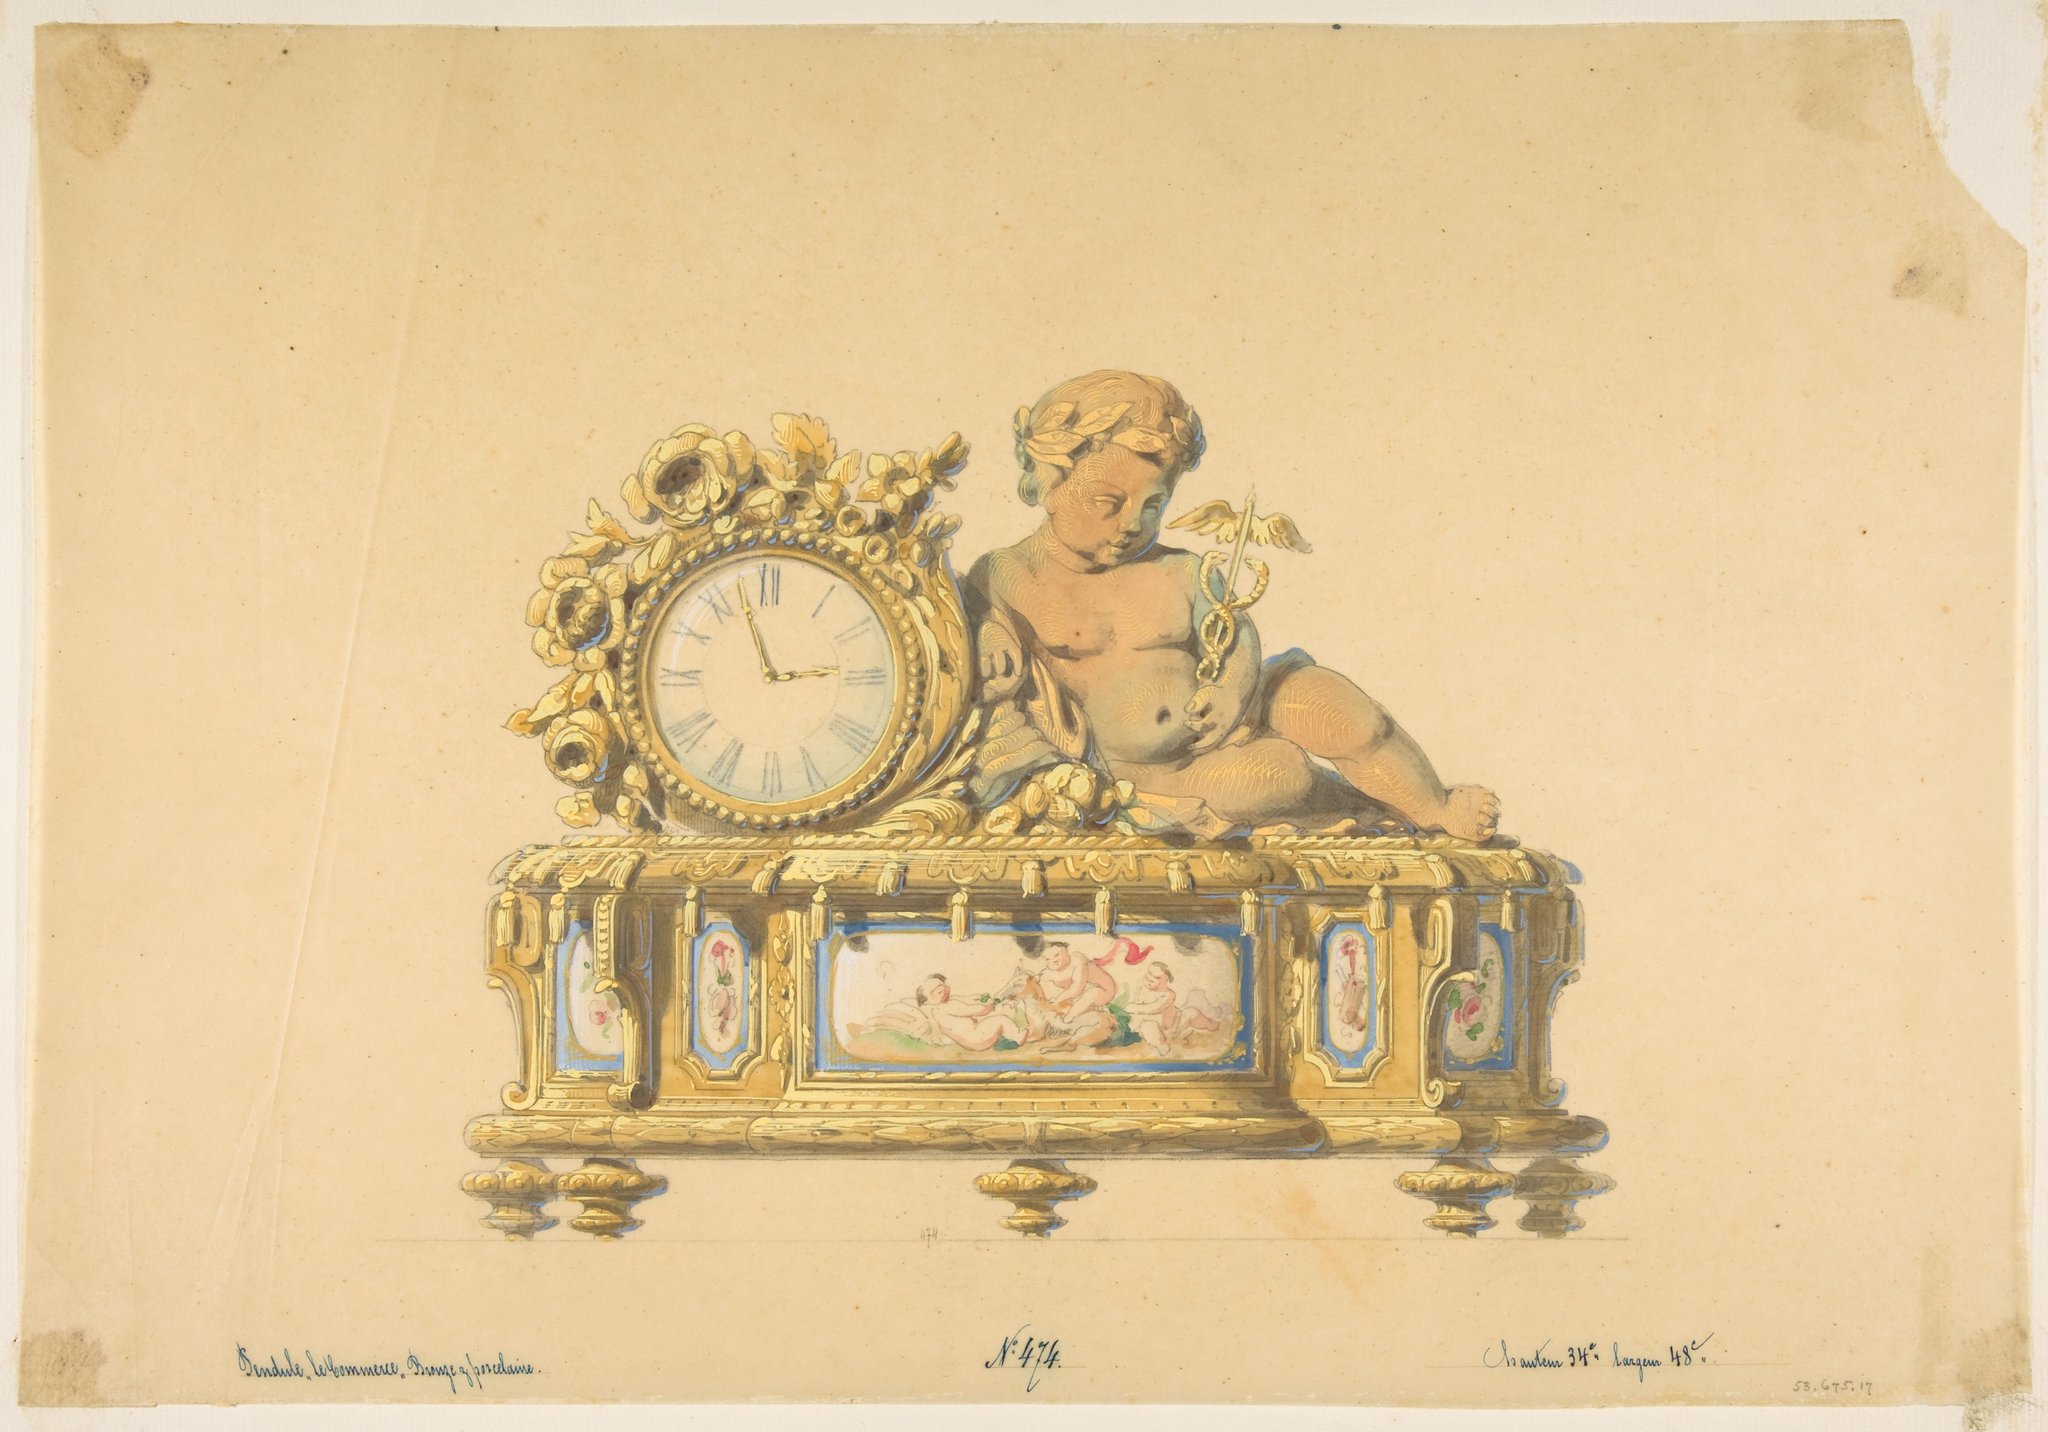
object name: drawing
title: Design for a Clock: Commerce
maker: anonymous, french, 19th century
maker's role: artist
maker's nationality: french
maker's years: 1800-1900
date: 1801-1900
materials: gilt, gold, gouache, graphite, watercolor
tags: children,clocks